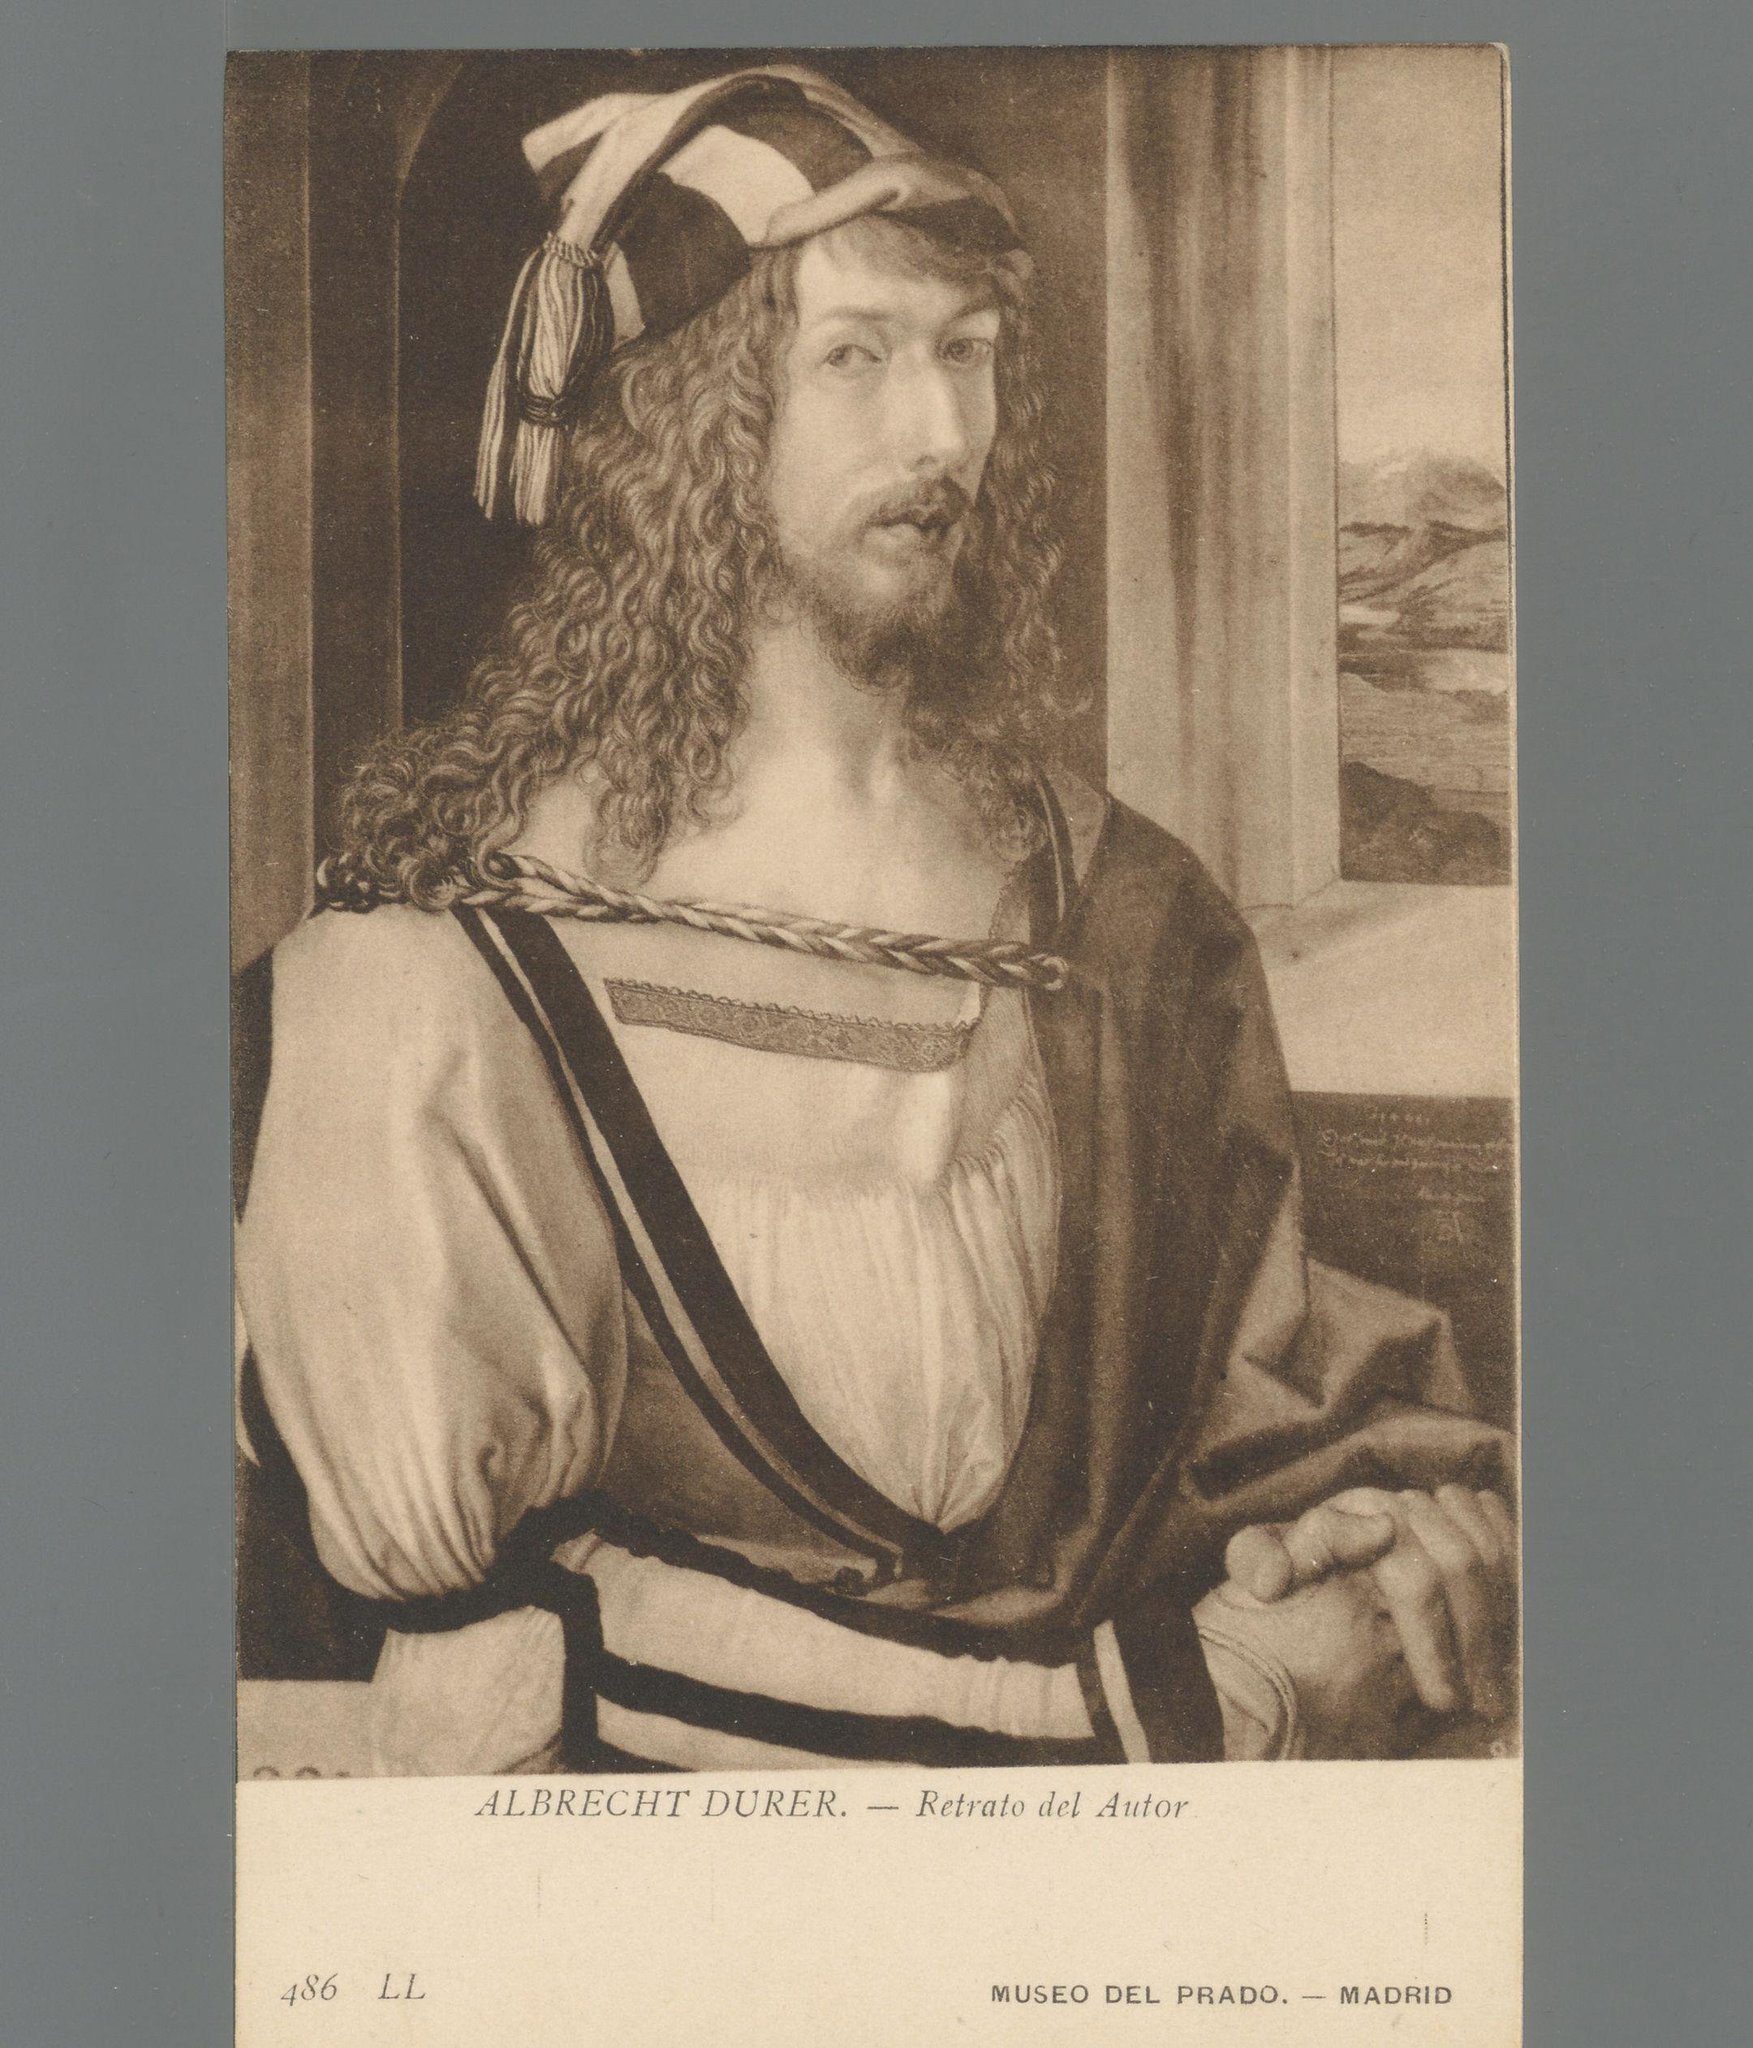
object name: reproduction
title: Albrecht Durer - Retrato del Autor. Museo del Prado. Madrid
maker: Anonymous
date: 1905-1932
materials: cardboard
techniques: photograph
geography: paris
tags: print maker, draughtsman, albrecht dürer, portrait, self-portrait of painter, permanent exhibition, museum, picture, painting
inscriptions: collector's mark: ‘AFE v S’